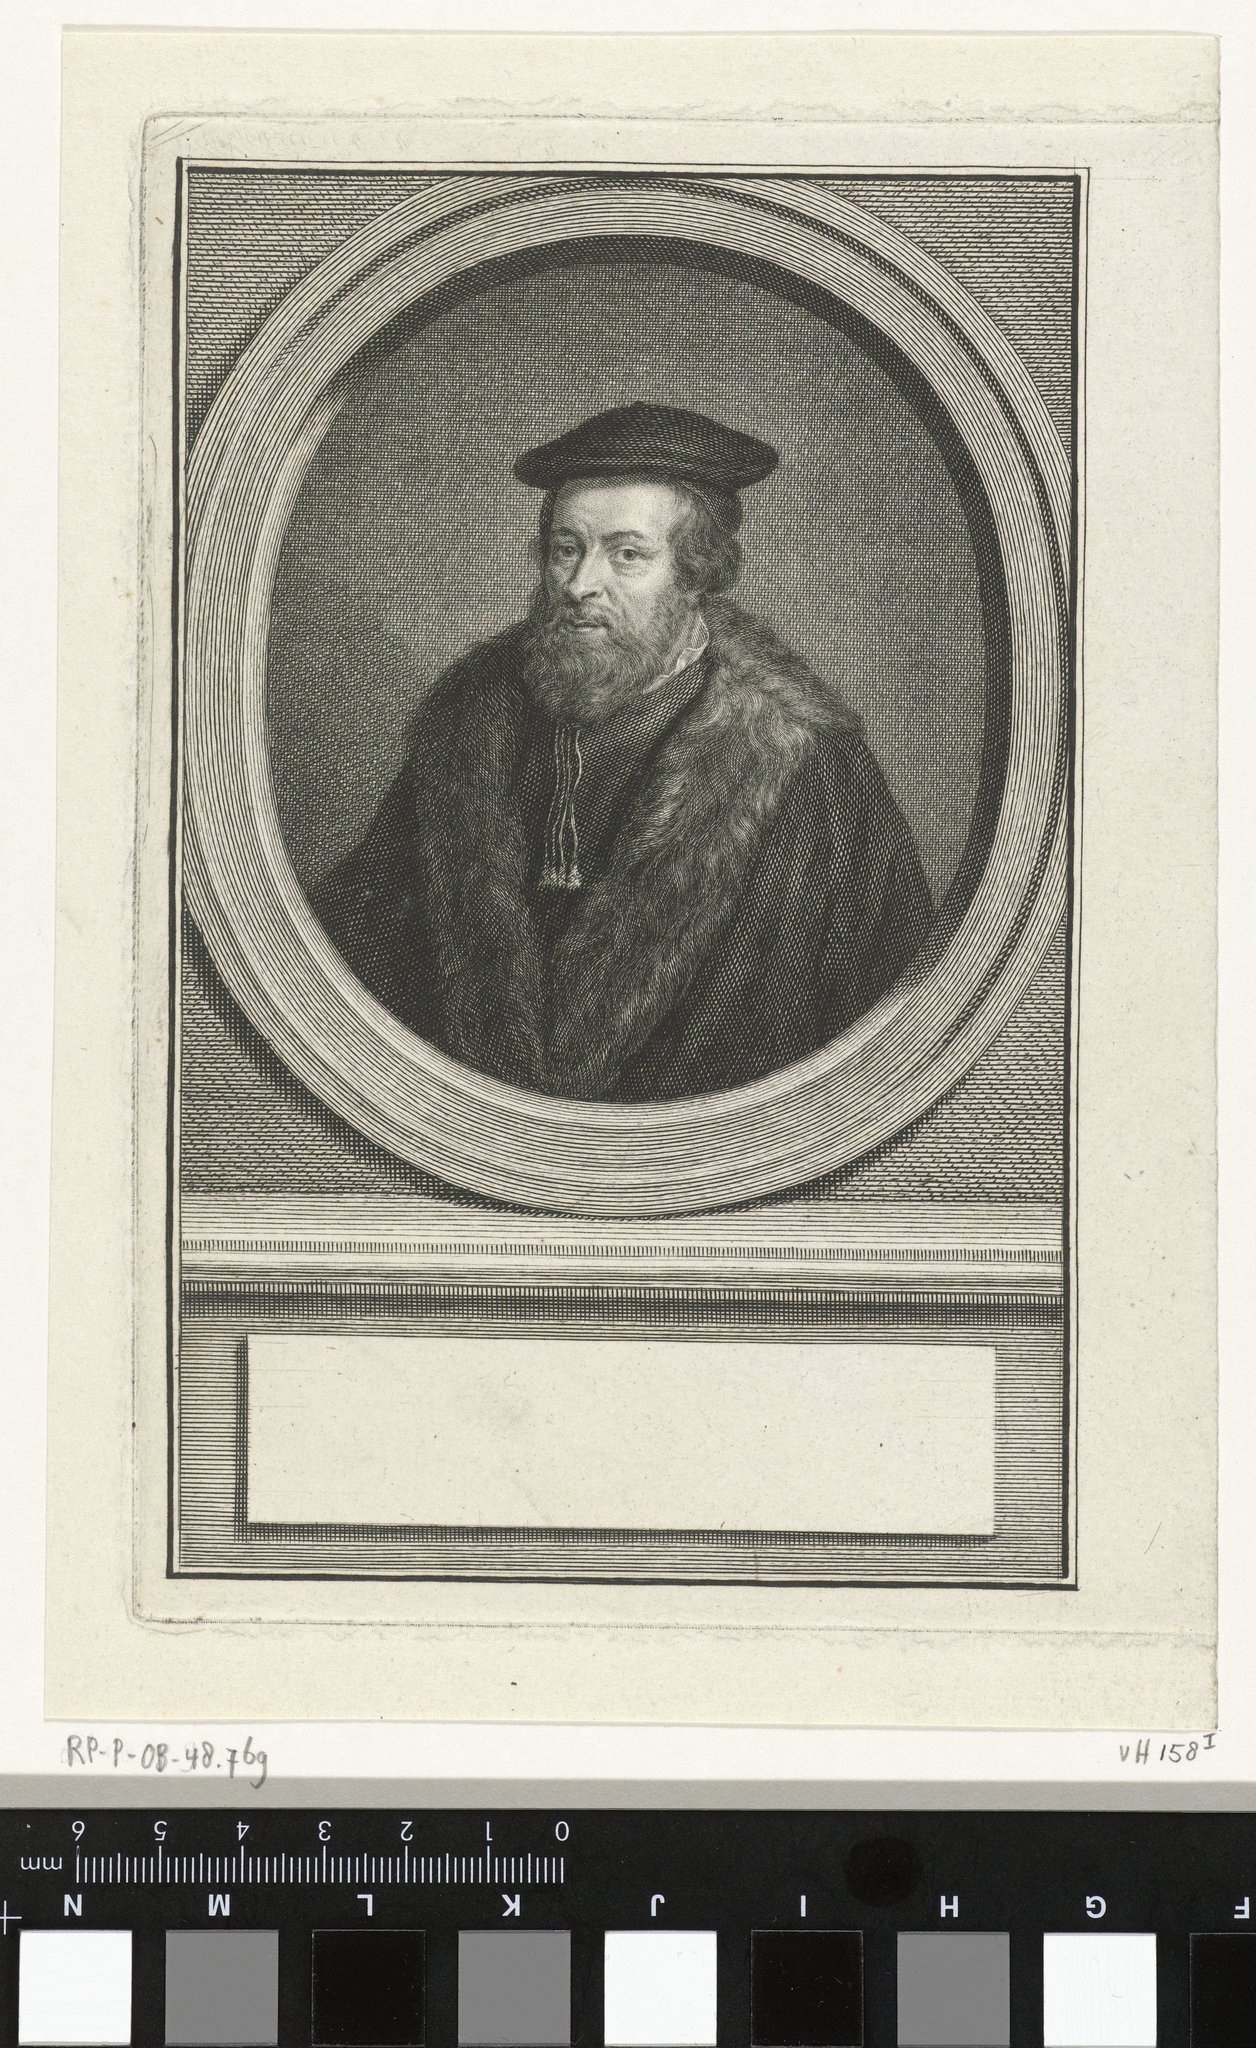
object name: print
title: Portret van Adriaan van der Goes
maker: jacob houbraken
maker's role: draughtsman, print maker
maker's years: 1698-1780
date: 1747-1759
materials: paper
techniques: engraving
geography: amsterdam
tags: delft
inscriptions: collector's mark: Lugt 240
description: Proefdruk van de prent gebruikt in: Jan Wagenaar, Vaderlandsche historie, vervattende de geschiedenissen der nu Vereenigde Nederlanden, inzonderheid die van Holland (...), 21 delen. Amsterdam, Isaak Tirion, 1749-59.